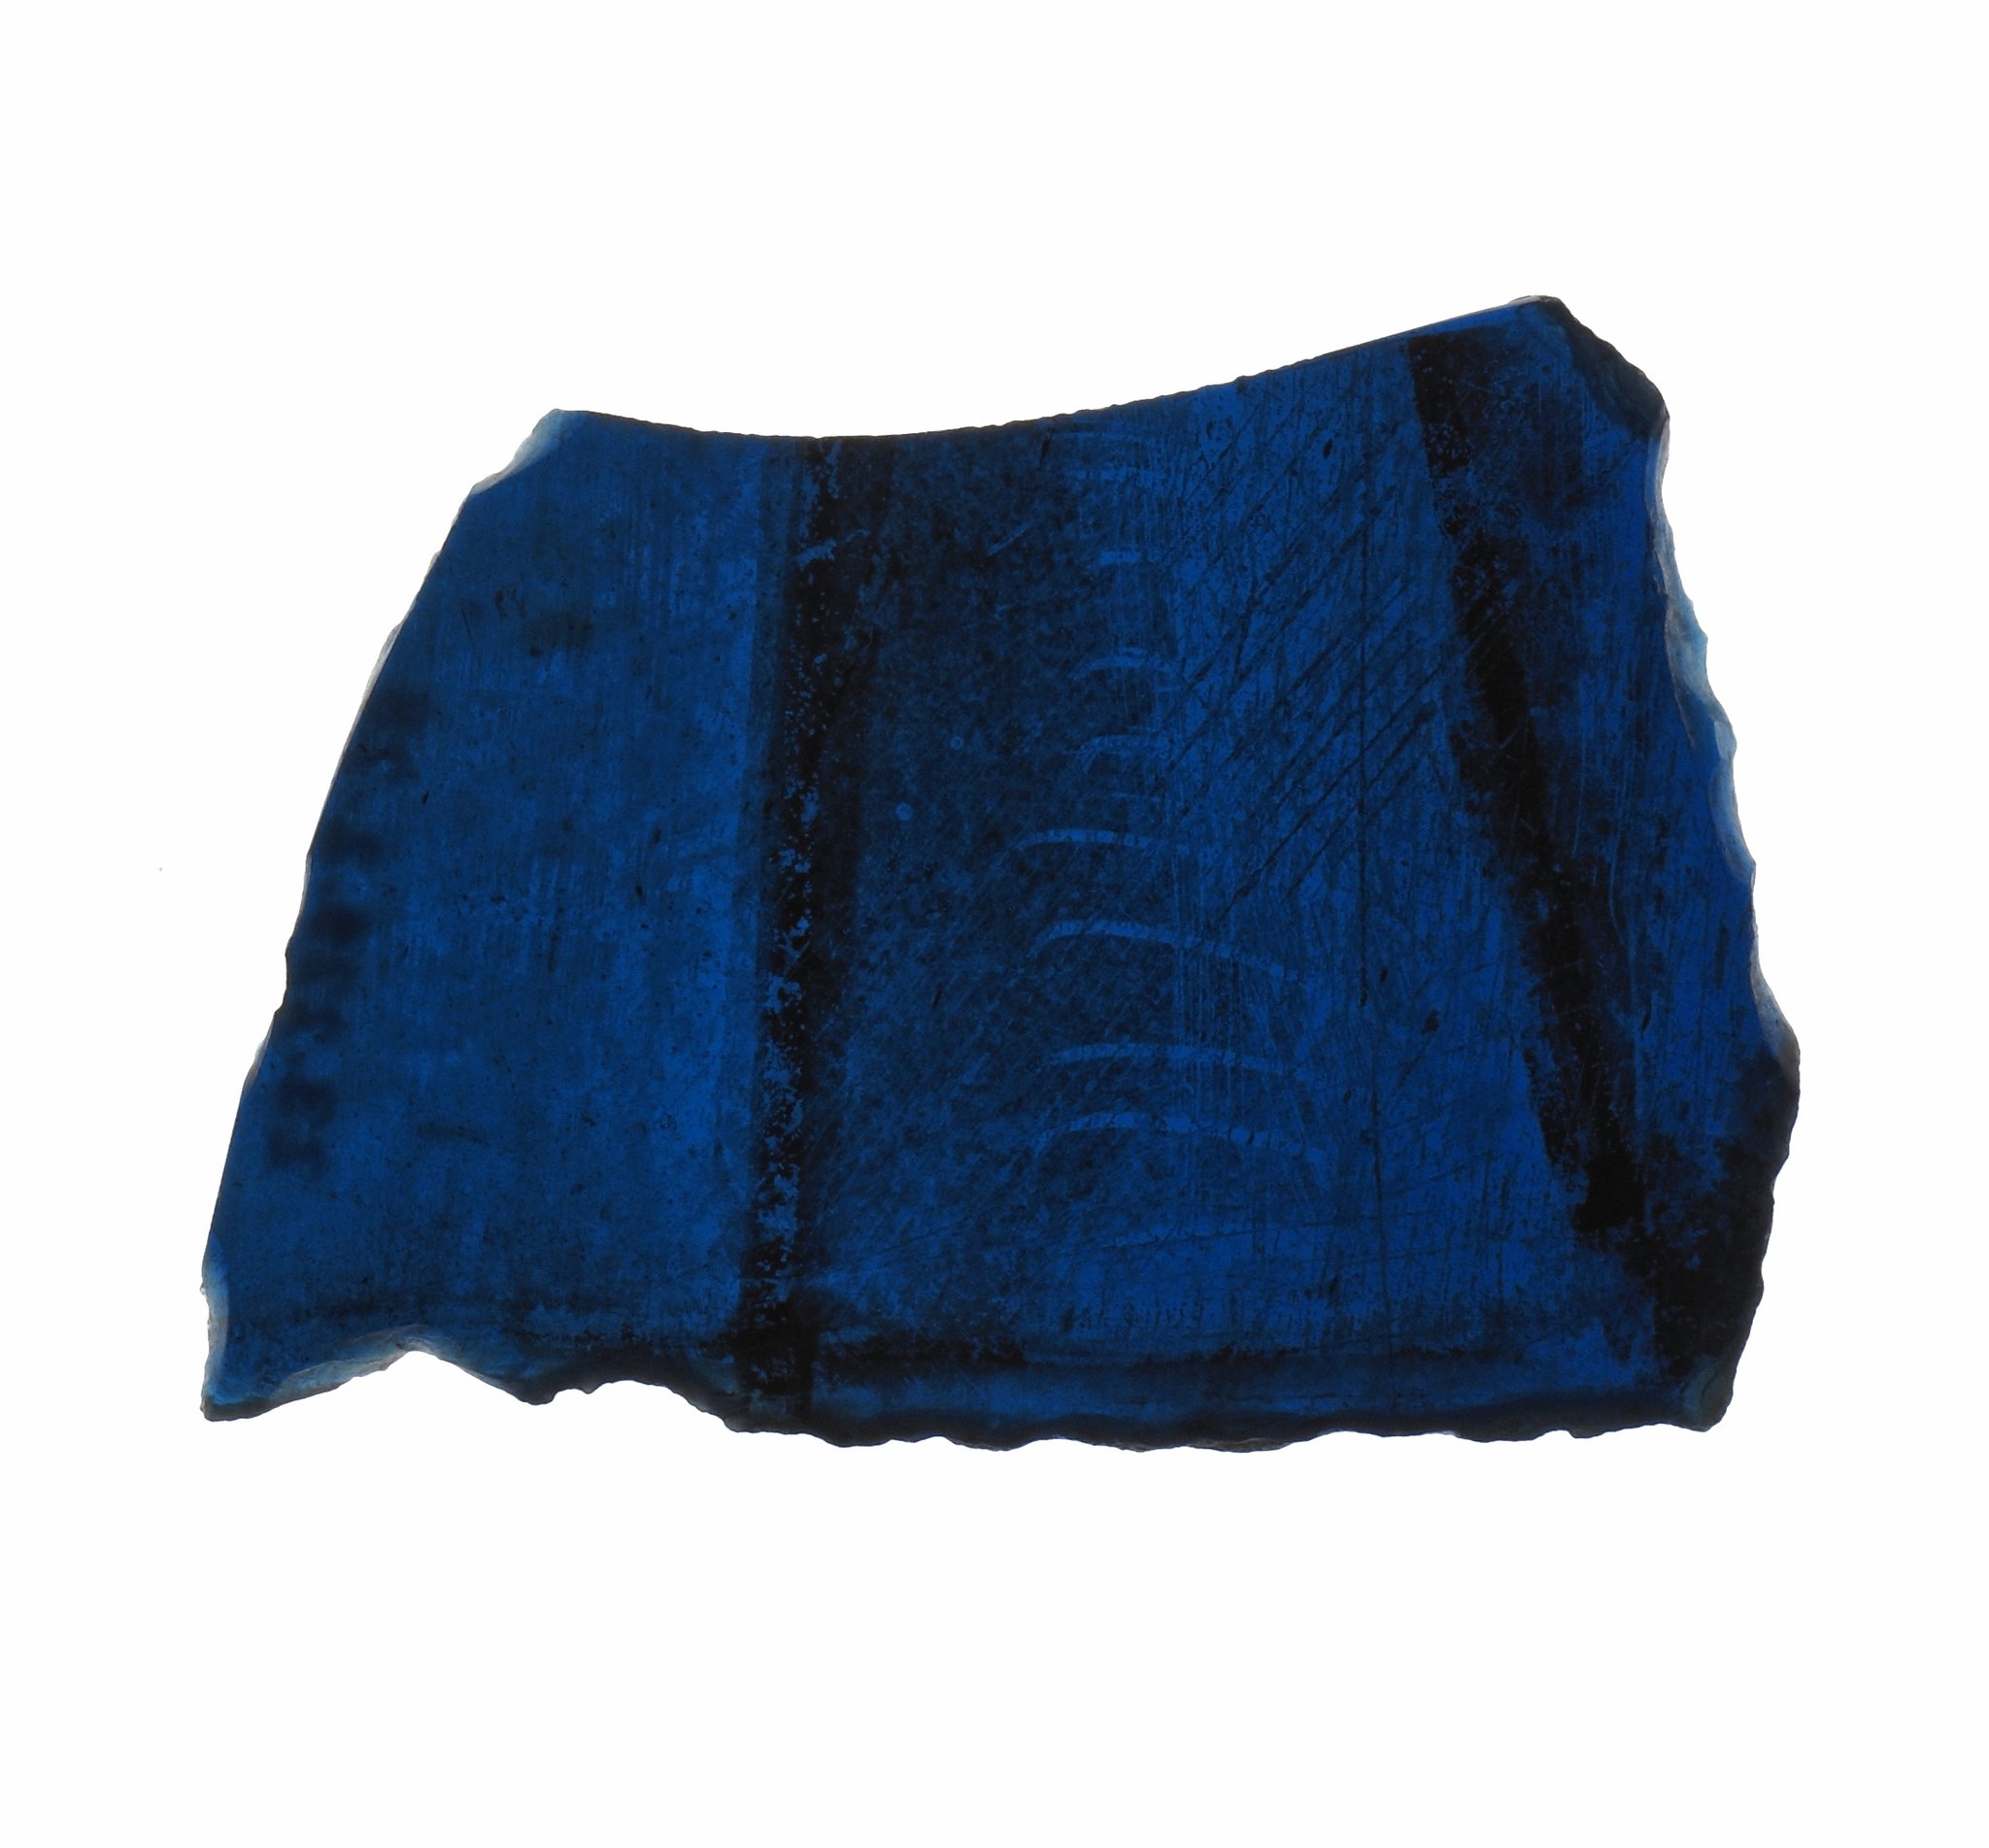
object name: fragment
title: Glass Fragment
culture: french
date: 1401-1600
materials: glass, metal